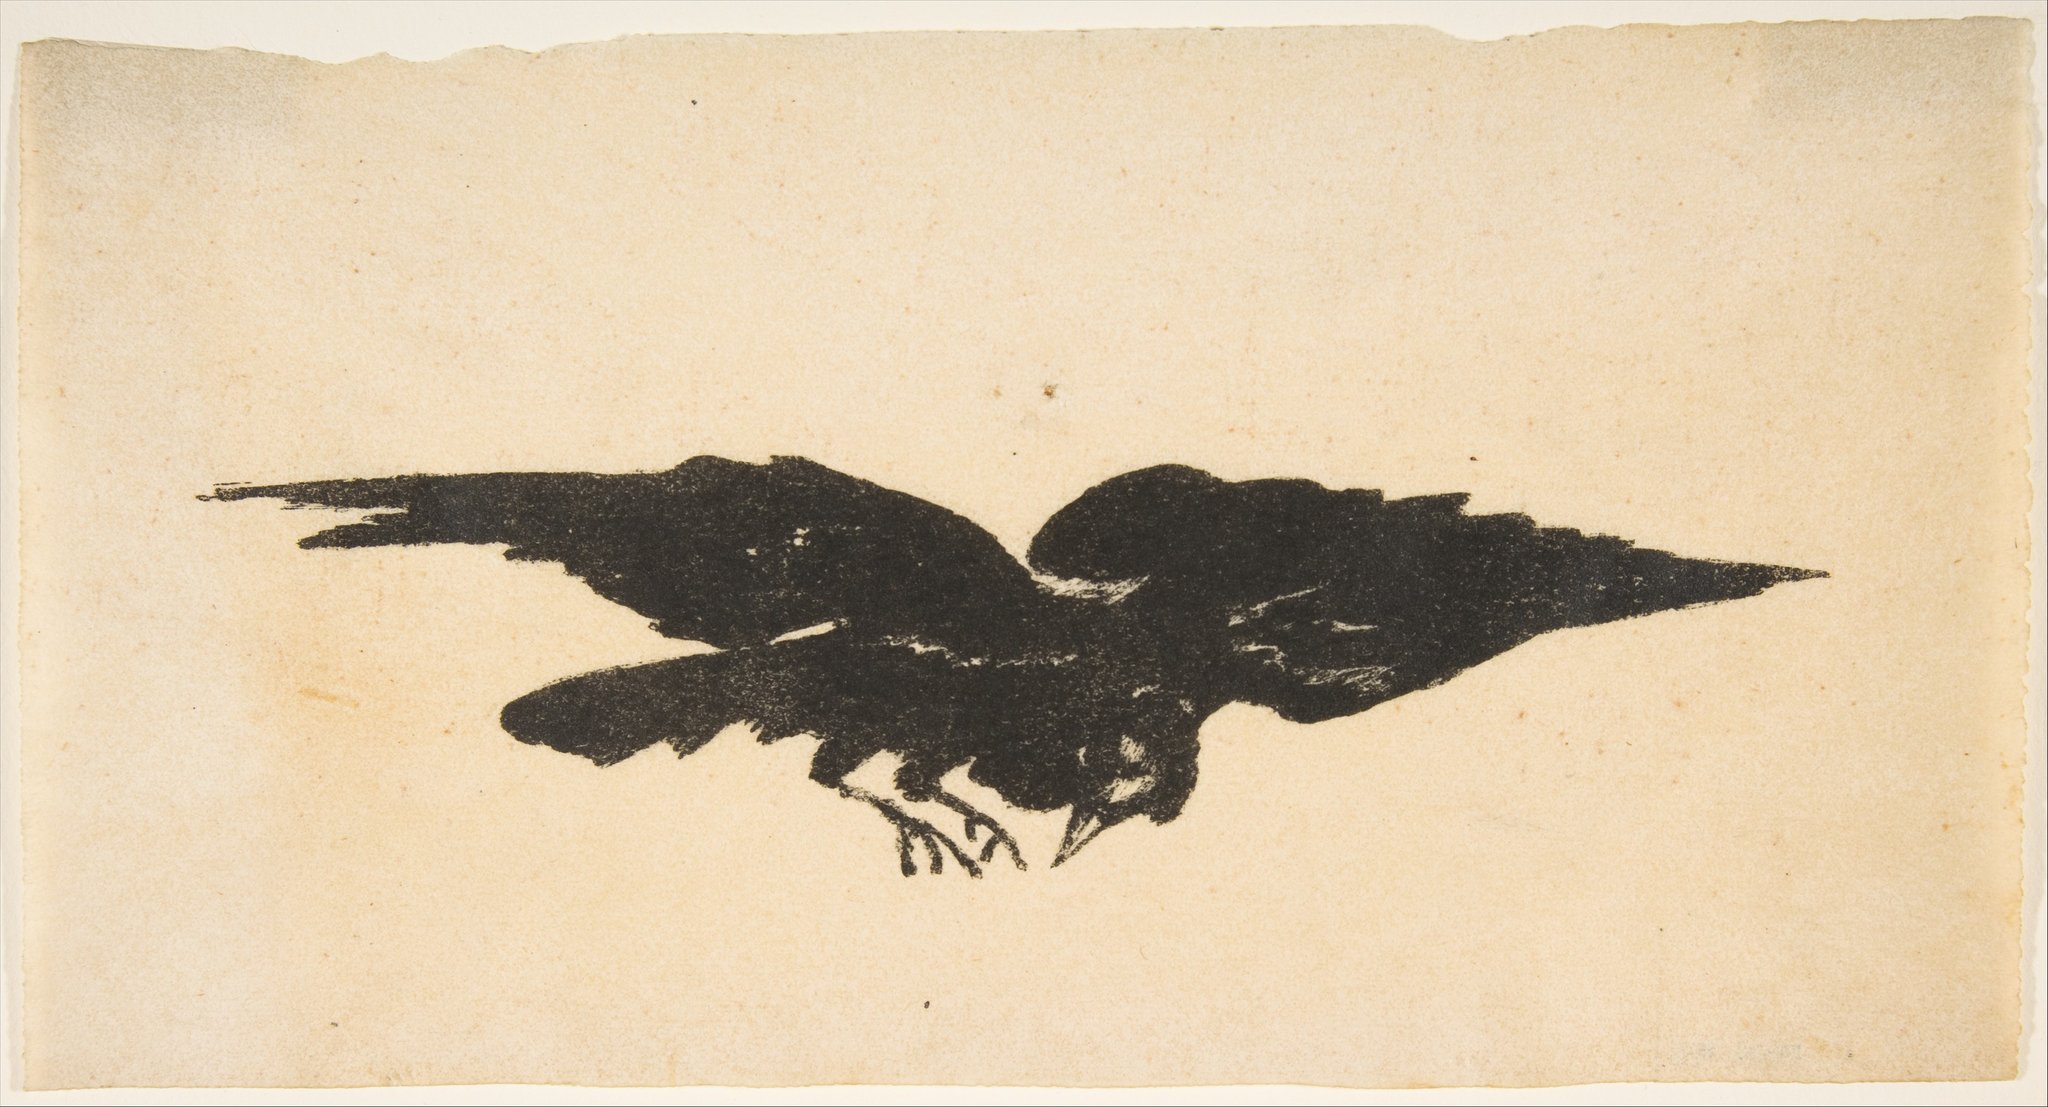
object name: print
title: The Flying Raven, Ex Libris for "The Raven" by Edgar Allan Poe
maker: édouard manet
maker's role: artist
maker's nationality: french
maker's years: 1832-1883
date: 1875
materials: parchment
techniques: lithograph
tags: birds